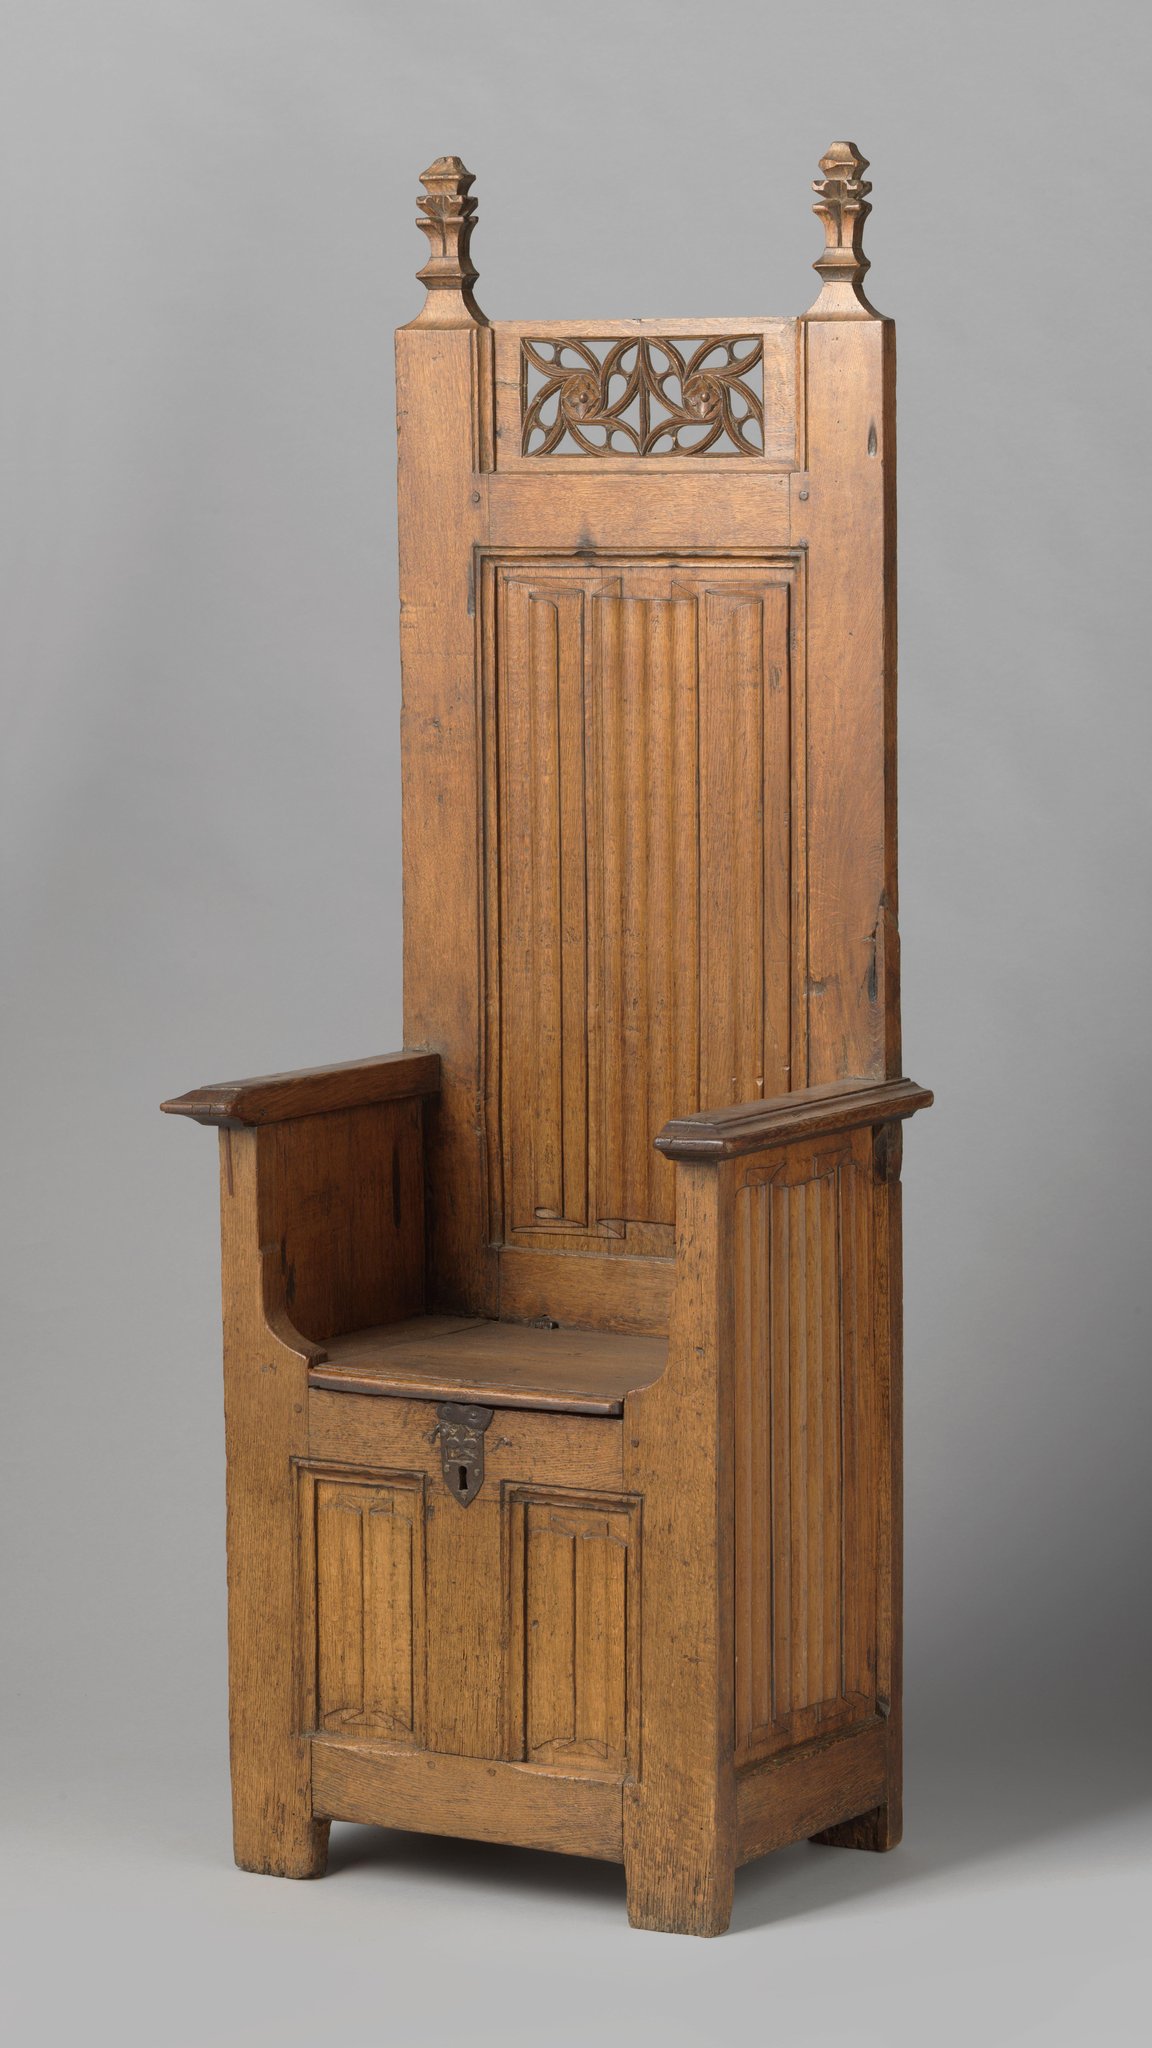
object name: chair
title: Stoel van eikenhout met gesloten kistvormig onderstel.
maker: Anonymous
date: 1500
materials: iron, wood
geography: southern netherlands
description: Armchair. Oak. Southern Netherlands, c. 1500.